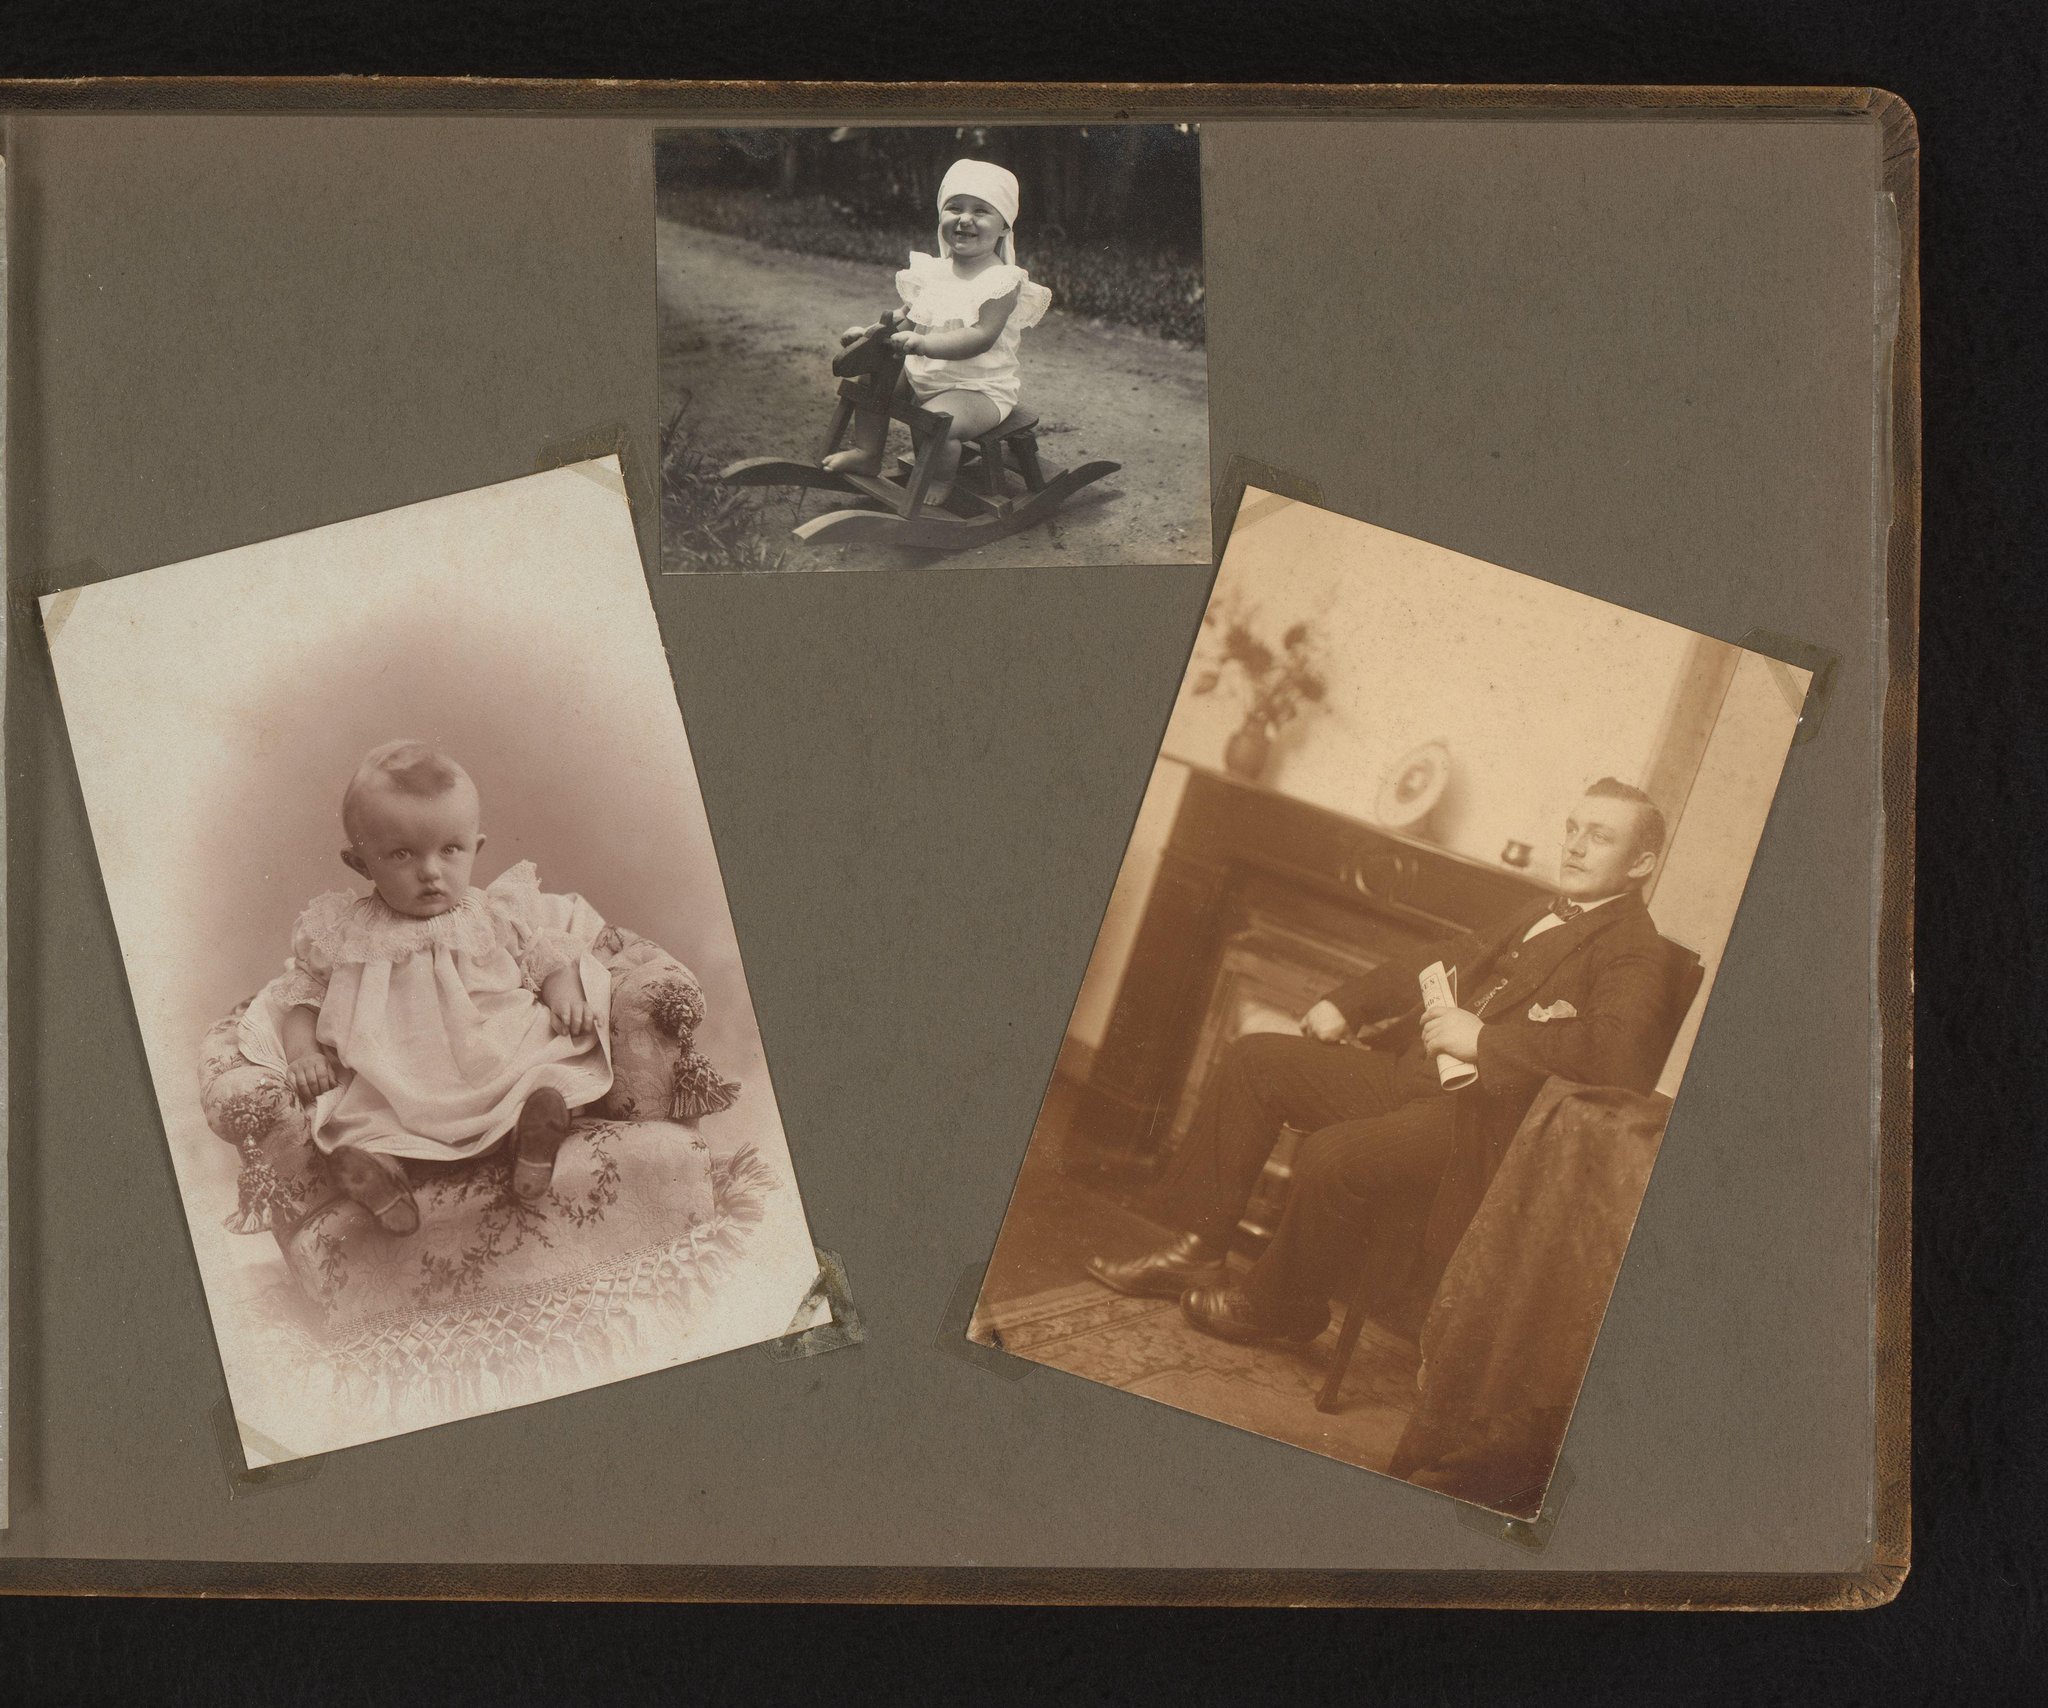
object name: photograph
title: Portretten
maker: Anonymous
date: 1900-1950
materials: photographic support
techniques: gelatin silver print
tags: adult man, historical persons, tot, toddler ~ the ages of man, rocking-horse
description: Twee portretten van peuters en een portret van een man. Deze pagina maakt deel uit van een album.